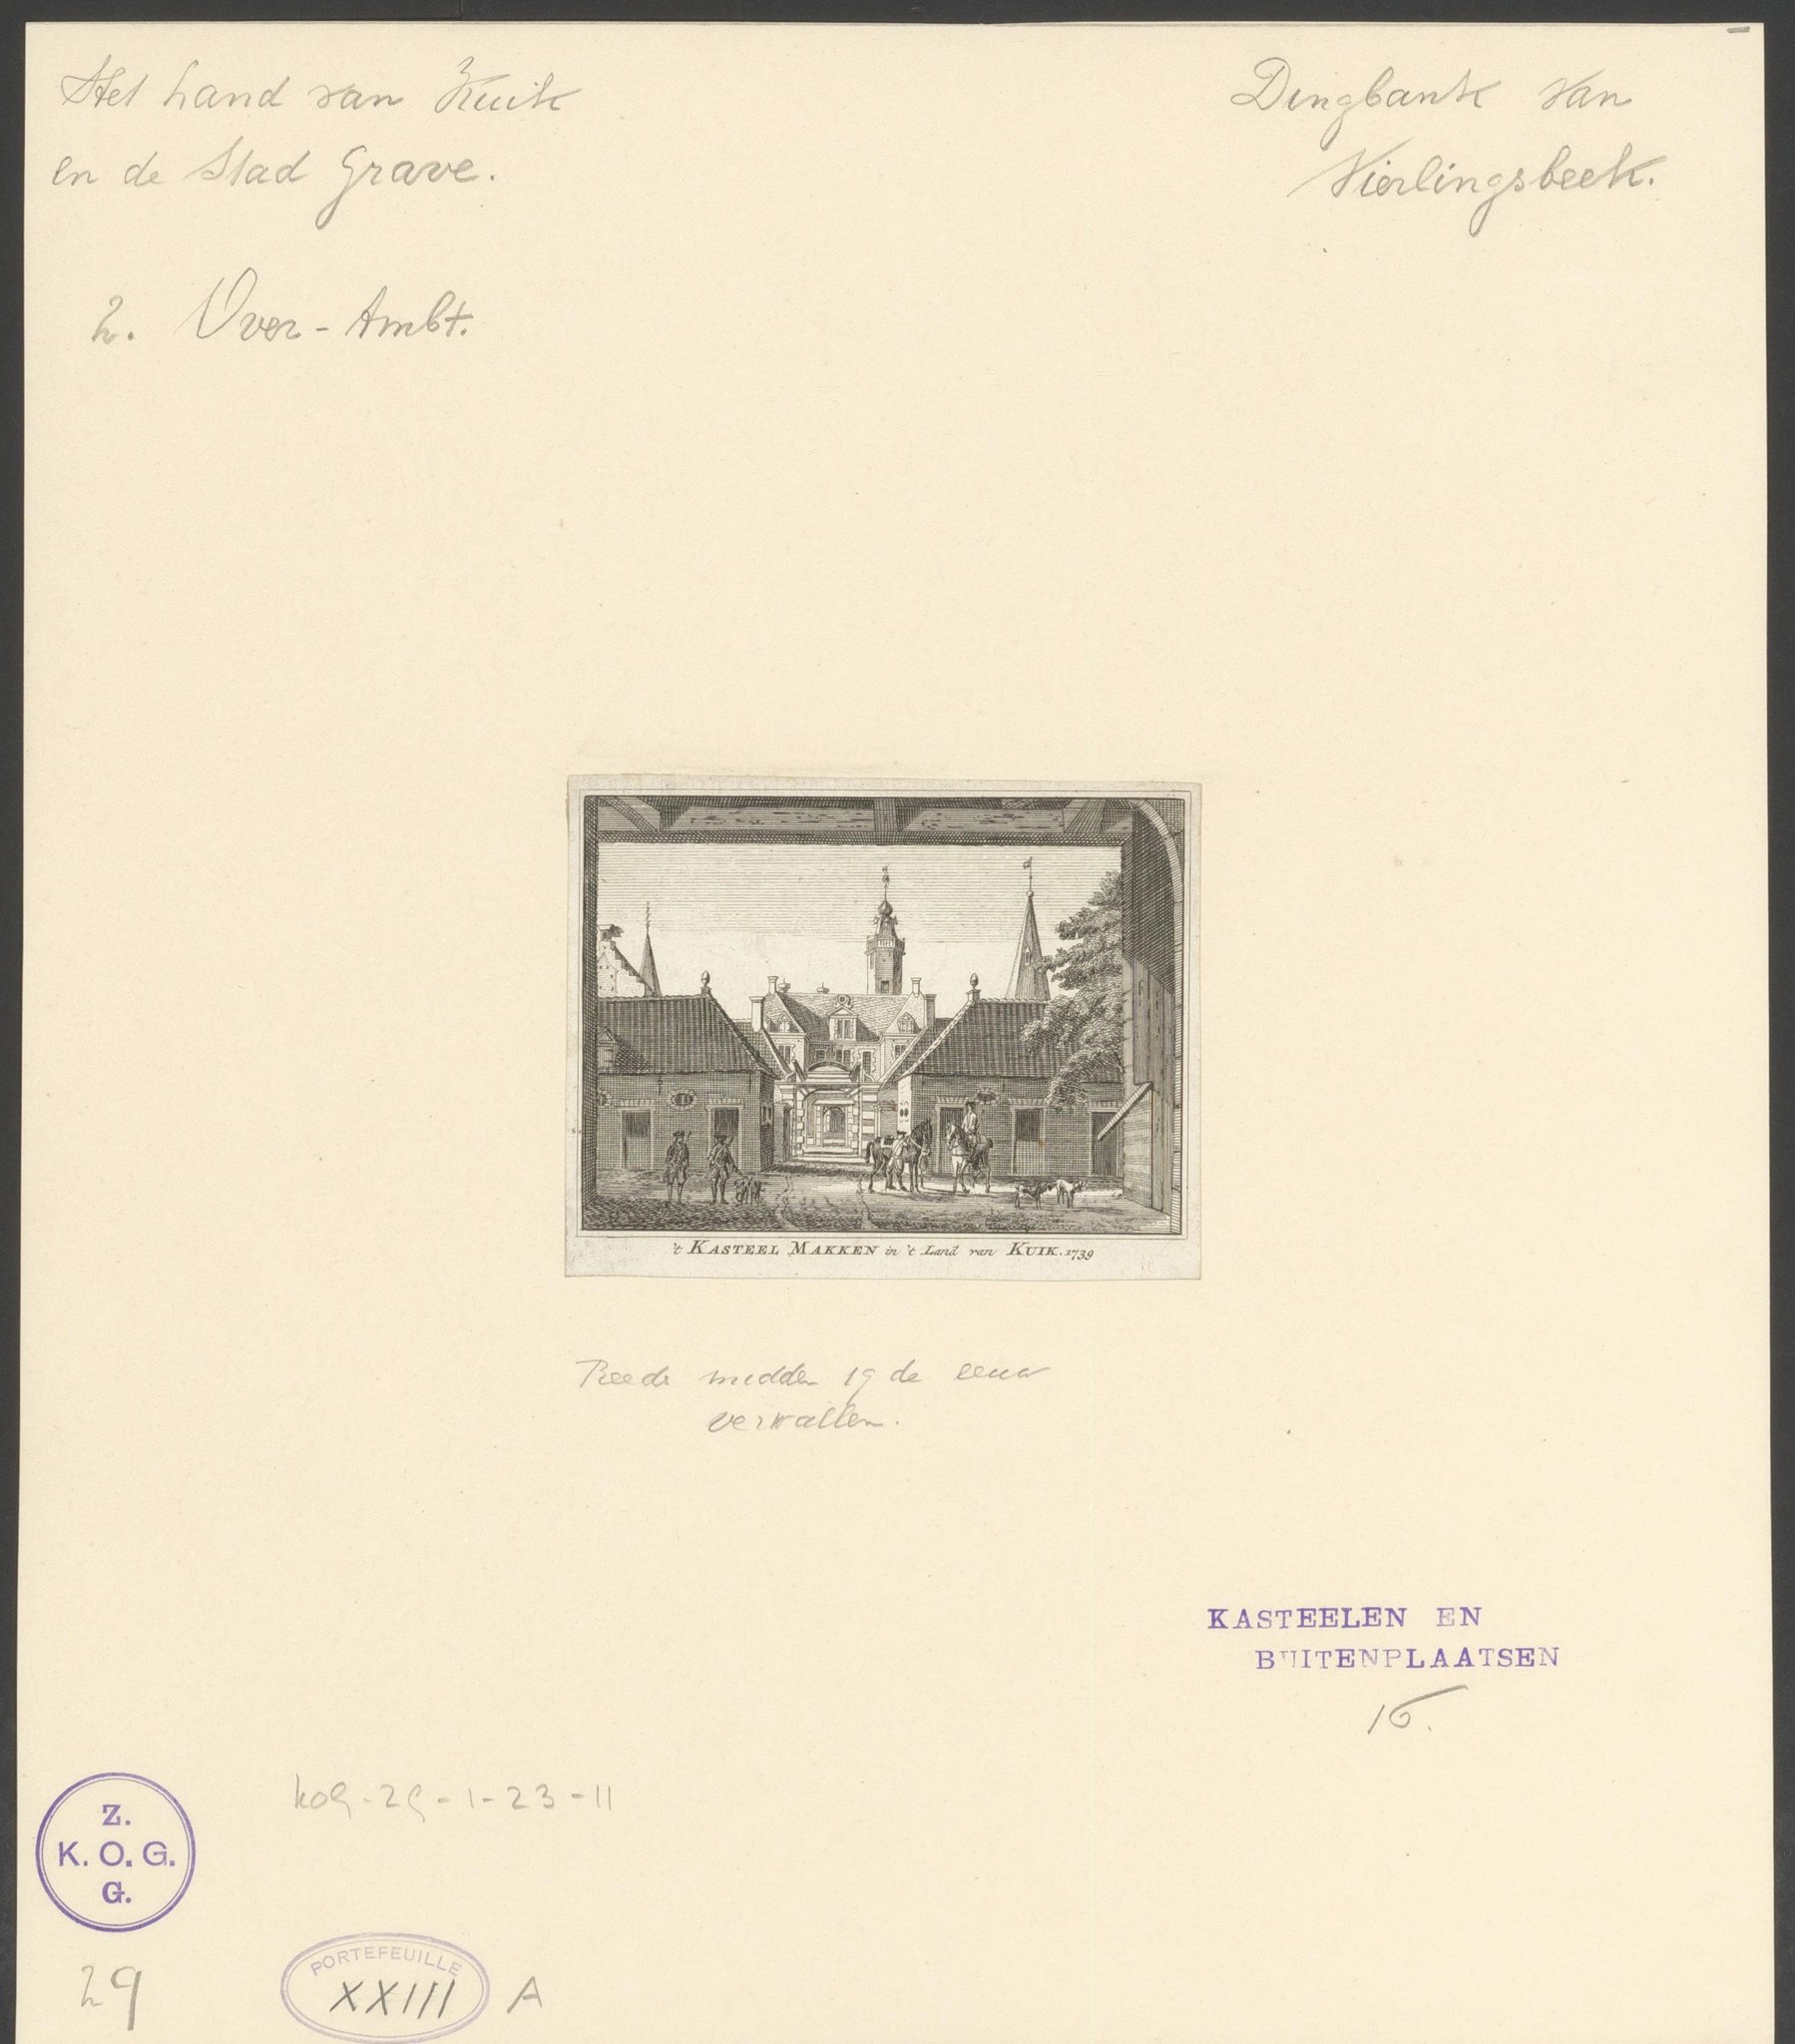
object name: book illustration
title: 't Kasteel Makken in 't Land van Kuik. 1739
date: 1745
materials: paper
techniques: engraving, etching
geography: amsterdam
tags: castle, inner court of palace or 'hôtel'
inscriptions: stamp, collector's mark: Lugt 1641, stamp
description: Gezicht op het Kasteel Het Makken bij Vierlingsbeek, in de situatie omstreeks 1739. Onderwerpsrubrieken binnen de Atlas Zeden en Gewoonten: Zeden en Gewoonten in Engeren Zin, De Woning. Kastelen en buitenplaatsen. Generaliteitslanden.